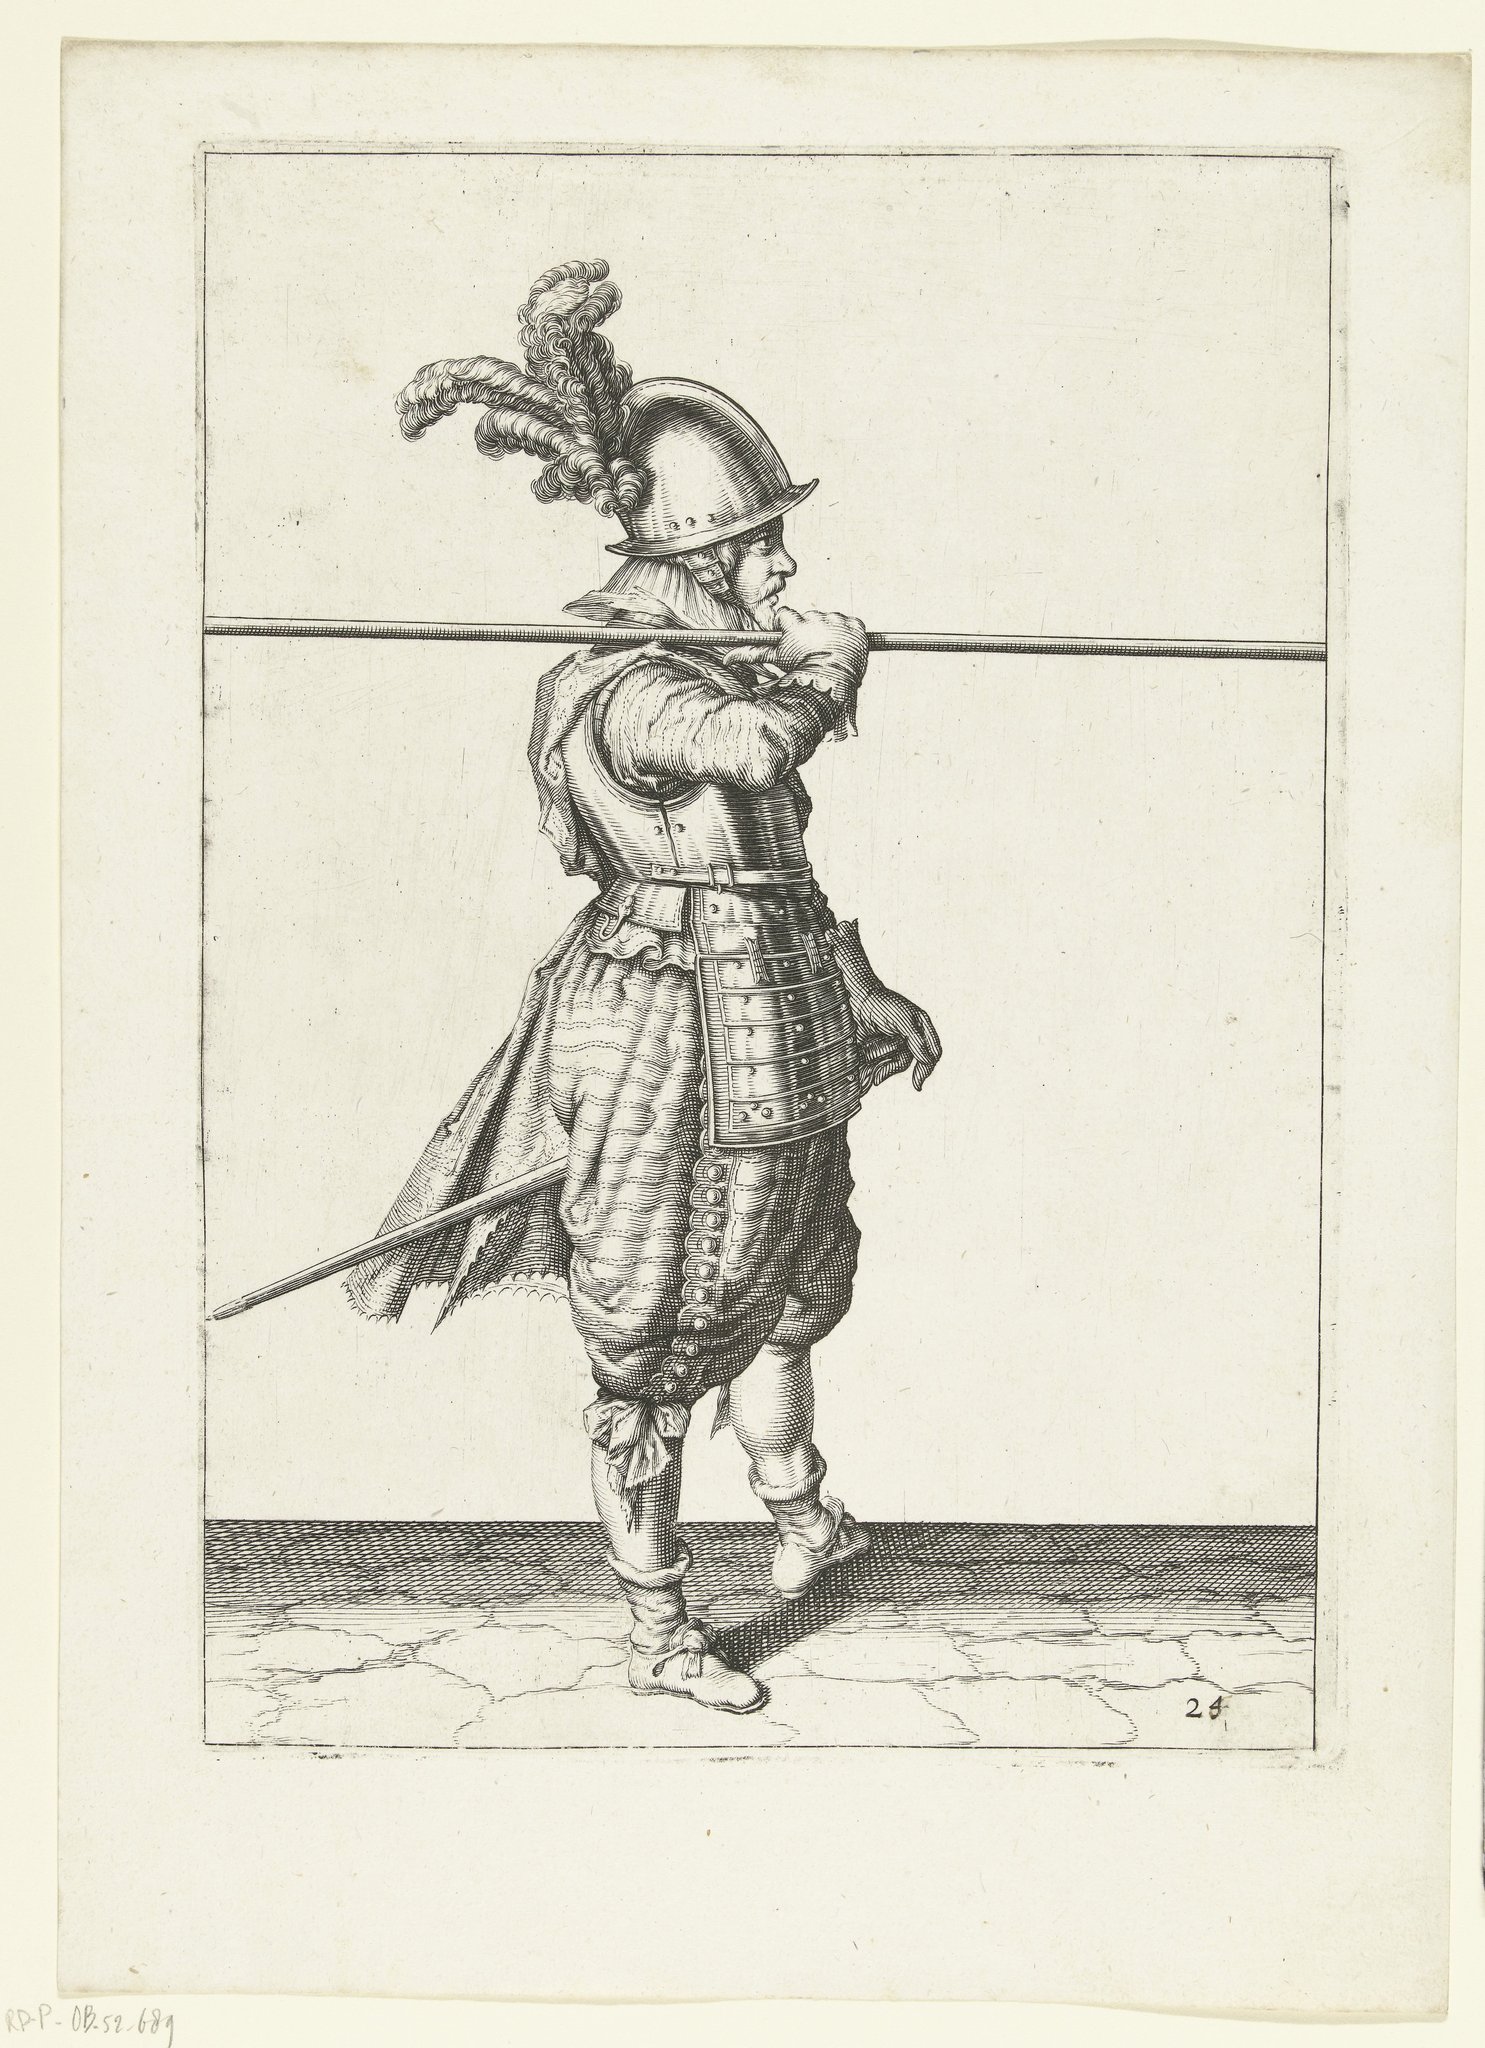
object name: print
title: Wapenhandelinghe van Roers Musquetten ende Spiessen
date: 1597-1607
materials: paper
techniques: engraving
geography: netherlands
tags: manoeuvre ~ military training, warfare; military affairs (+ mercenary troops, e.g.: lansquenets), helved weapons, polearms (for striking, hacking, thrusting): lance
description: Een soldaat, ten voeten uit, naar rechts, die een spies (lans) horizontaal op zijn rechterschouder draagt. Zijn rechterhand om de spies. Deze prent is onderdeel van de reeks van 32 genummerde prenten van spiesdragers uit de Wapenhandelinghe.